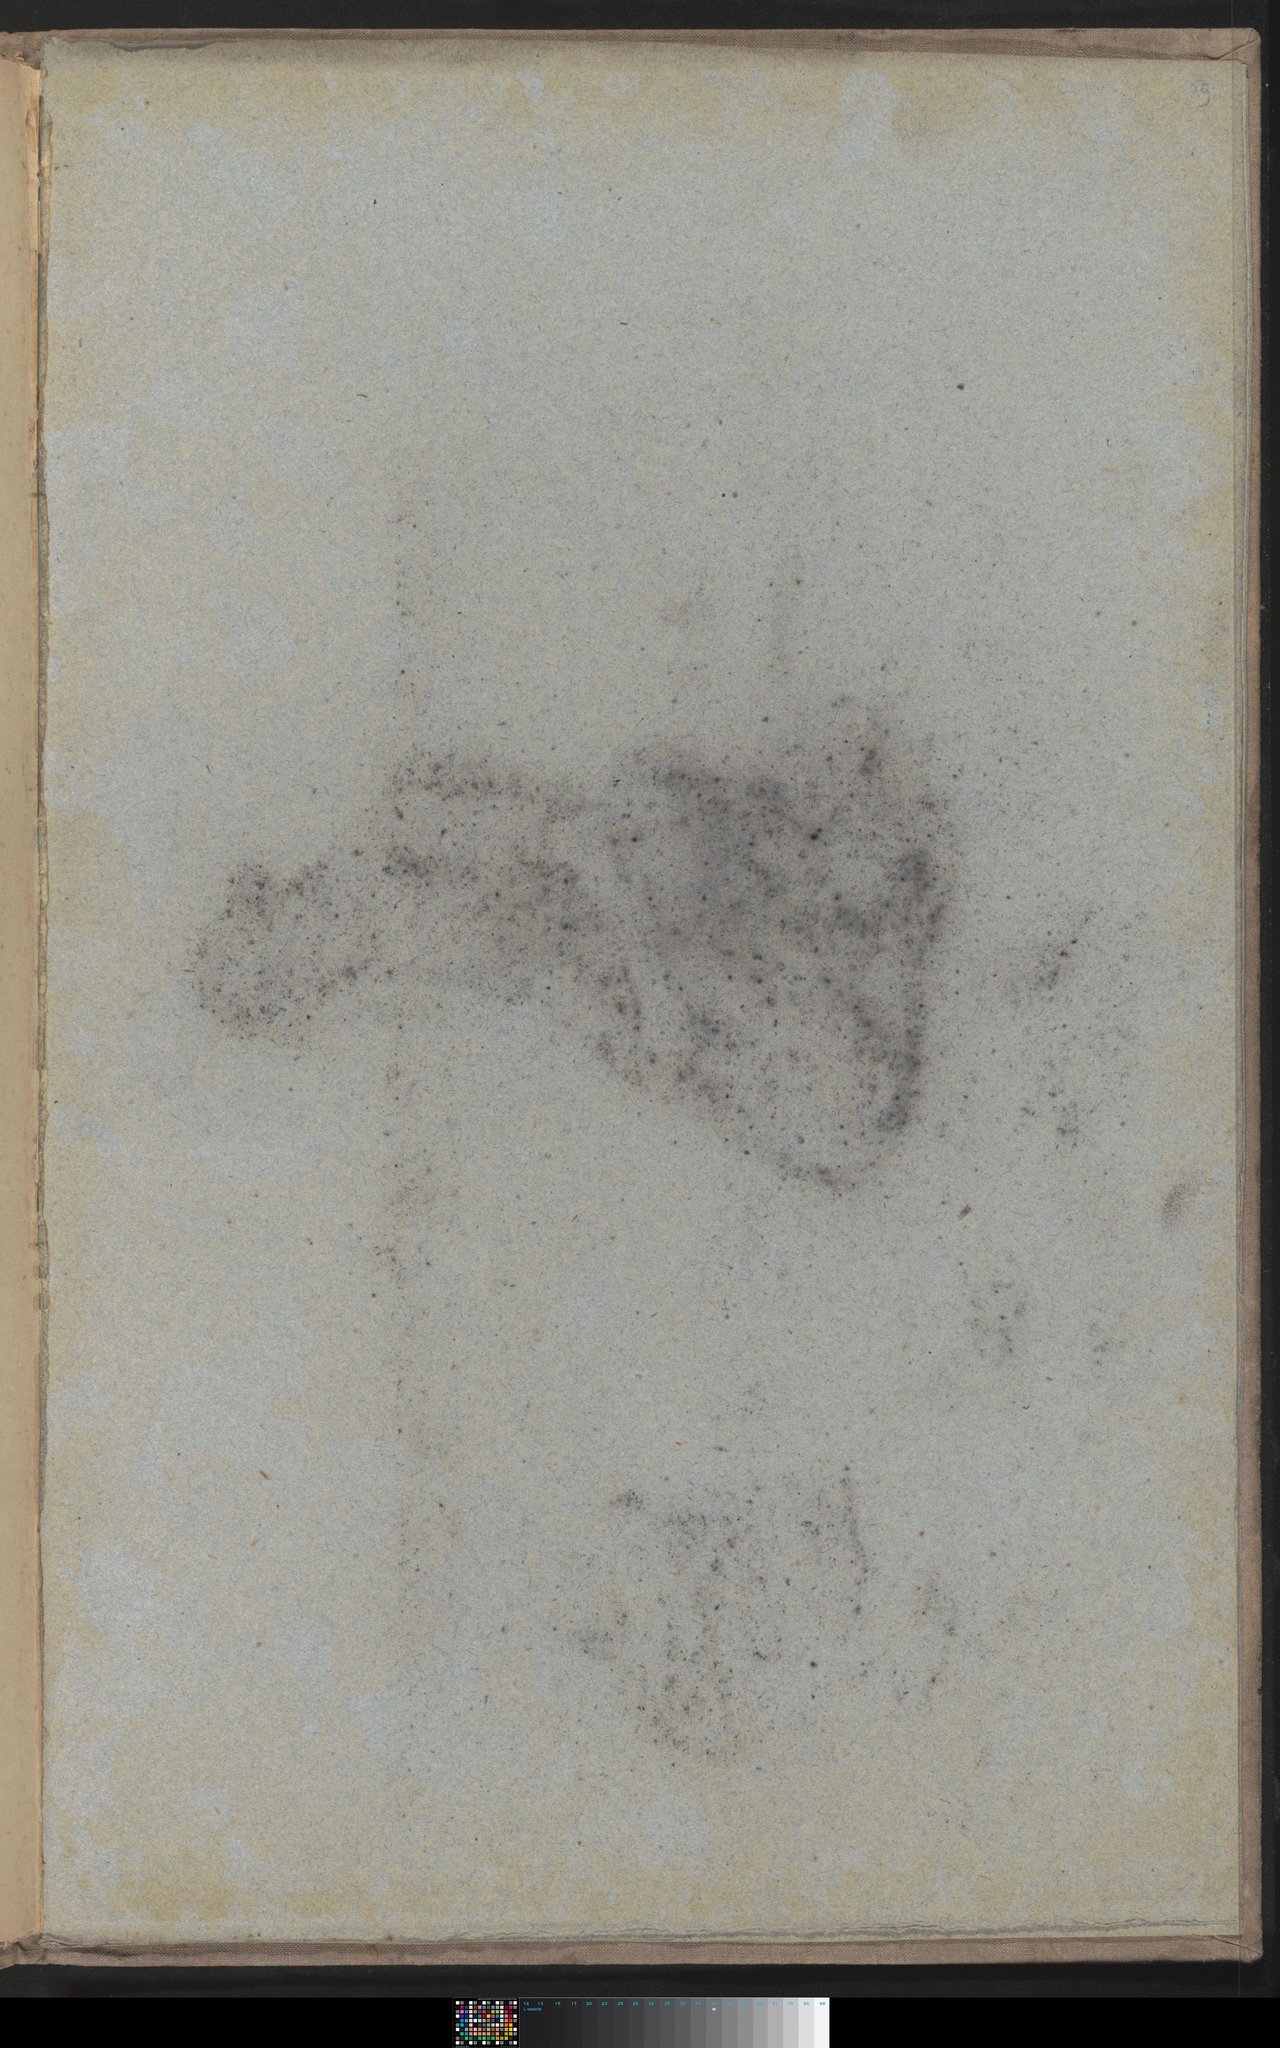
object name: sketchbook leaf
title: Abklatsch van de krijttekening op pagina 58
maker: willem witsen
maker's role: draughtsman, painter, print maker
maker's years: 1860-1923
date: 1886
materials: paper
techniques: printmaking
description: Pagina 59 uit een schetsboek met 38 bladen betekend rond de Ewijkshoeve.